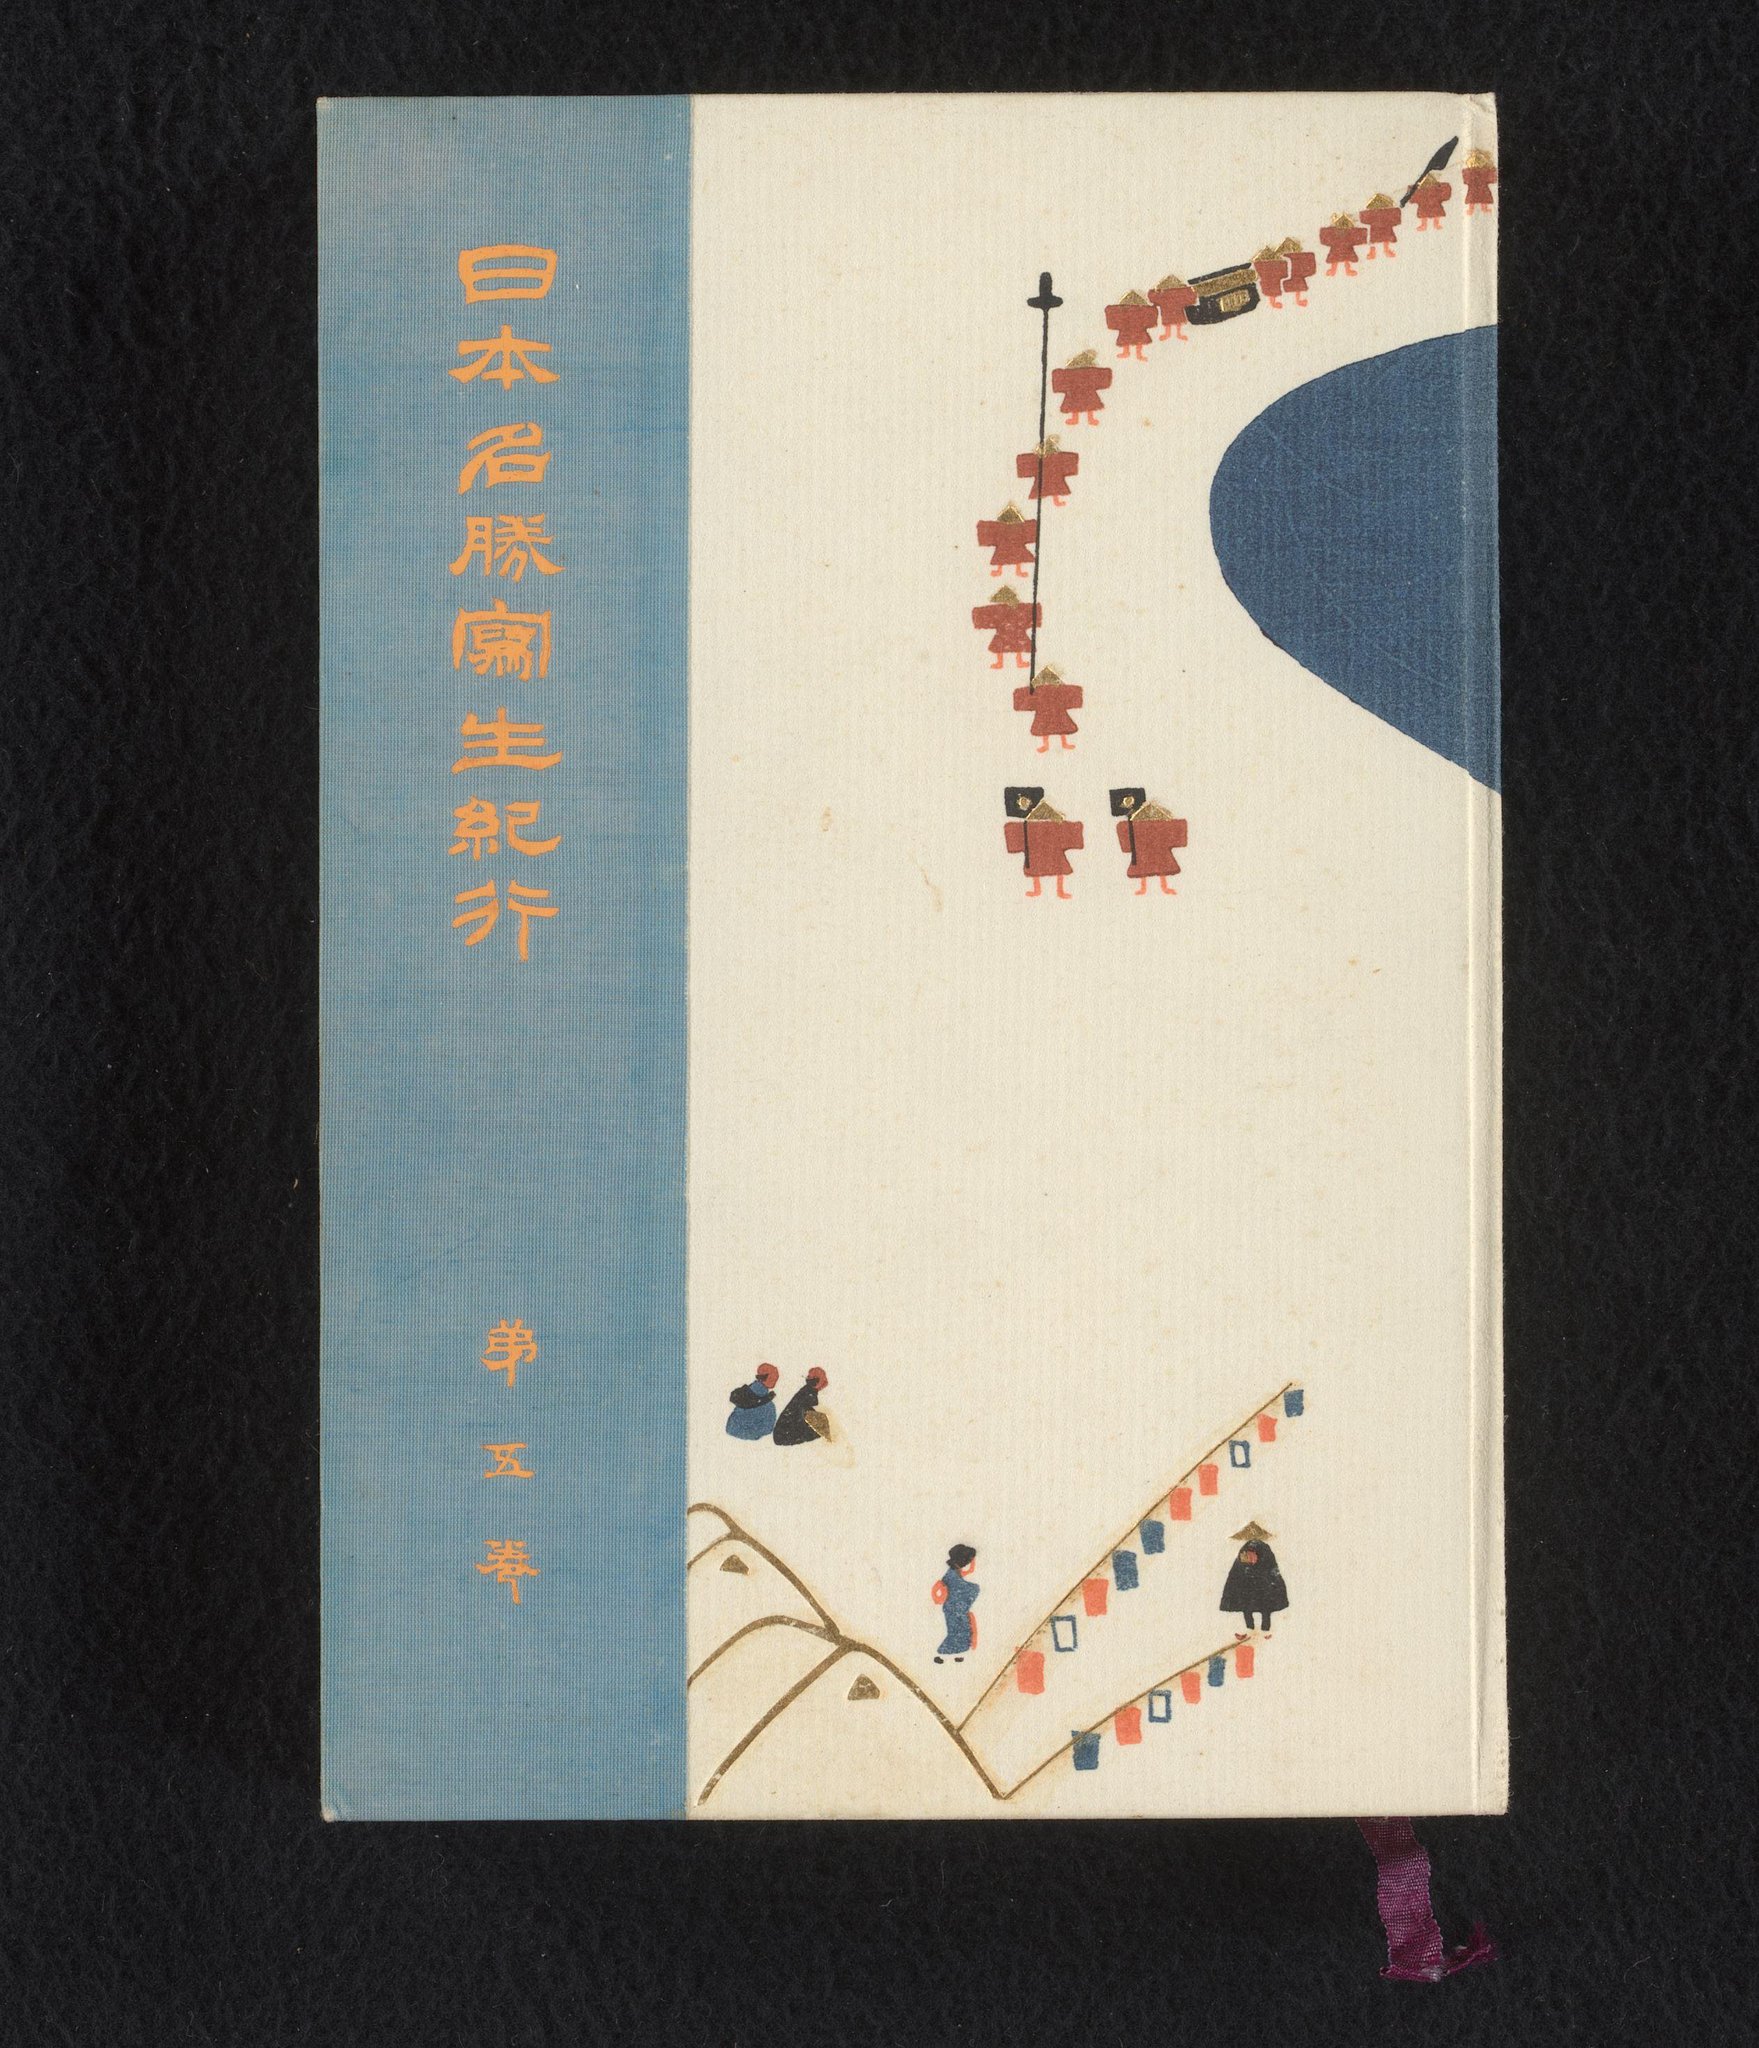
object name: book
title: Nihon meishô shasei kikô - dai go shû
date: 1912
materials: paper